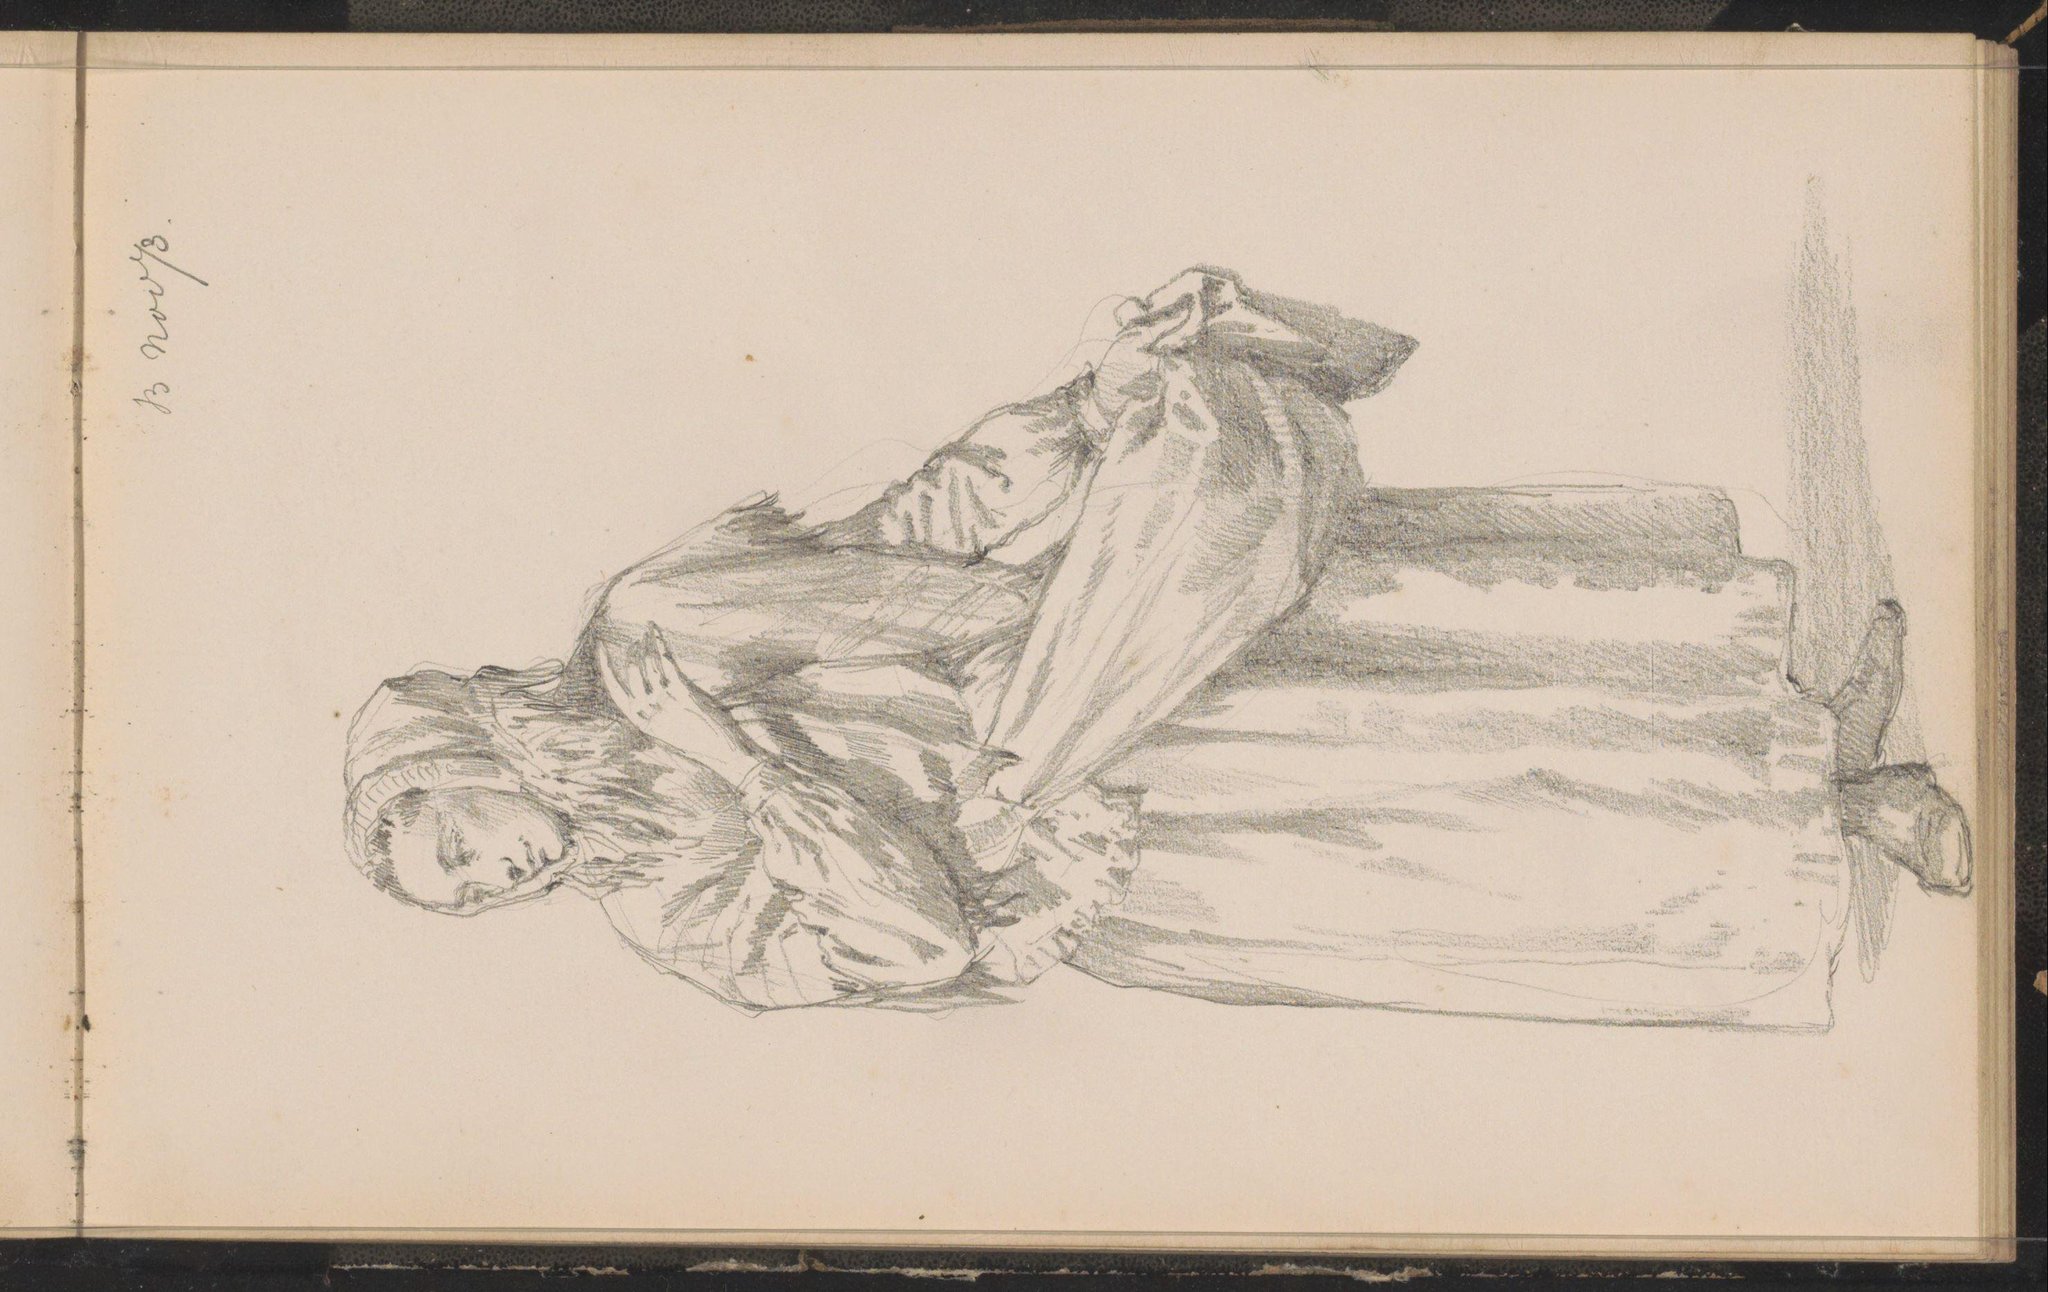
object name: sketchbook leaf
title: Vrouw met een omslagdoek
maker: cornelis springer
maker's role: draughtsman, painter, print maker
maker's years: 1817-1891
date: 1873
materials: paper, pencil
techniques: stumping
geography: netherlands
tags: standing figure - aa - female human figure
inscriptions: date: ‘13 nov 73’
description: Staande vrouw met een muts en een omslagdoek. Haar rechterarm heeft ze opgeheven en in haar linkerhand houdt ze een draperie of schort vast. Blad 22 uit een schetsboek met 46 bladen.